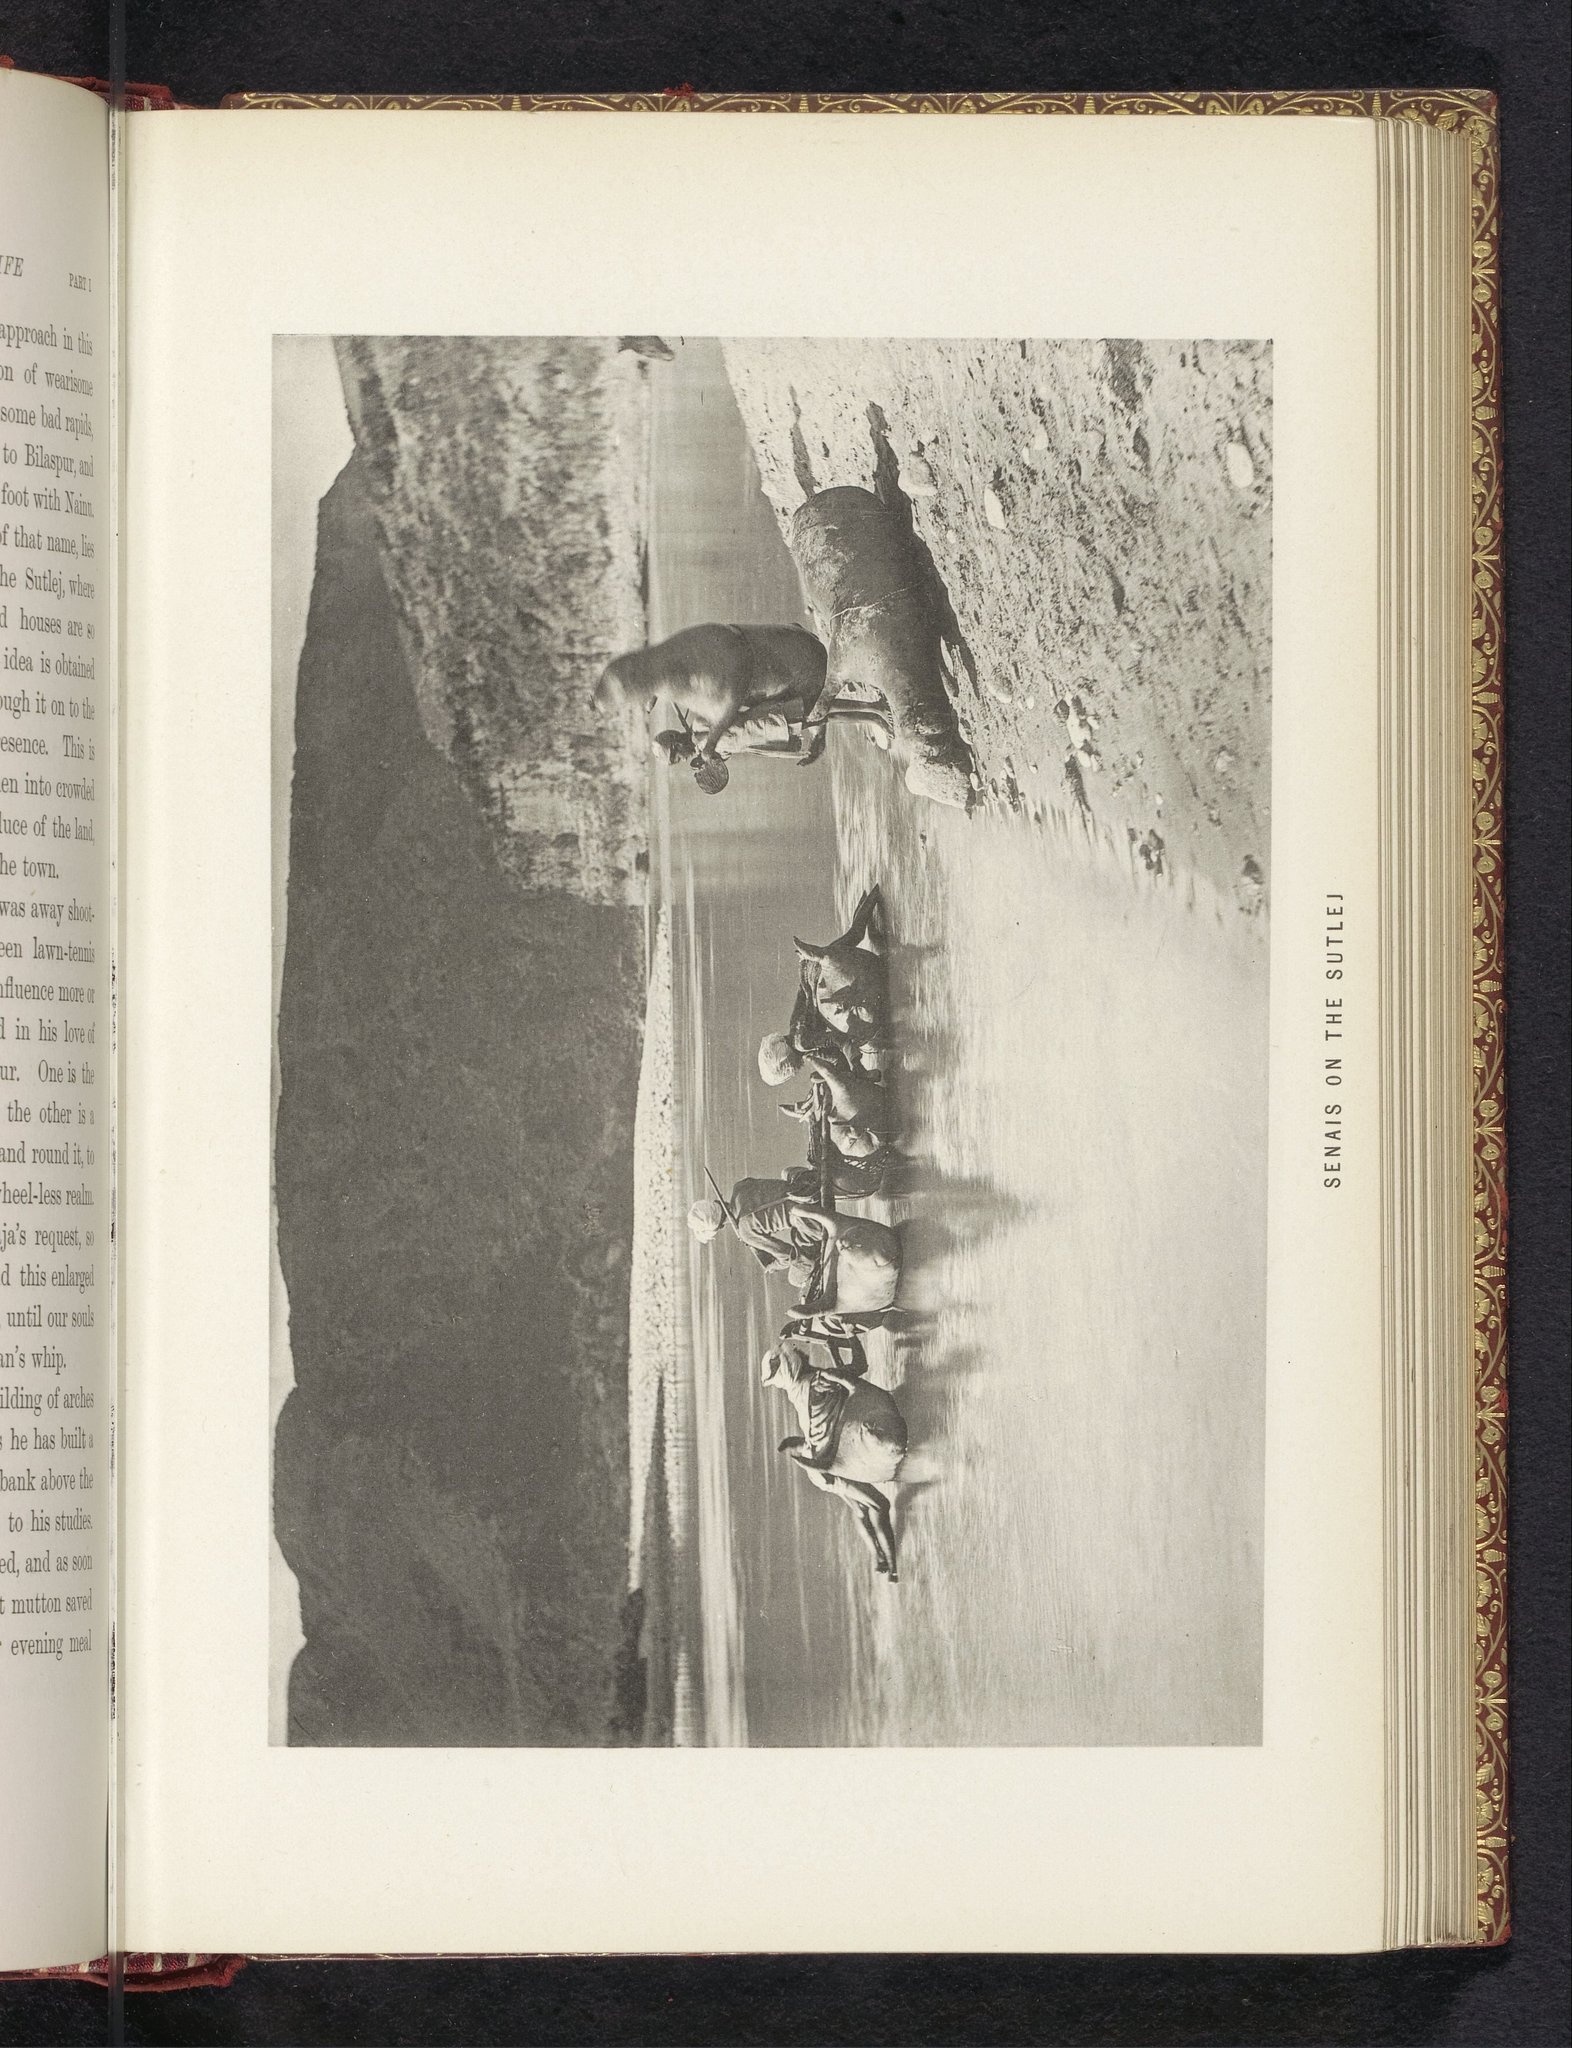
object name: page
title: View of Mandi, Himachal Pradesh, India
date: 1890-1895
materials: paper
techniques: photograph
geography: mandi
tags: city-view in general; 'veduta', river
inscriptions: caption: ‘MANDI’